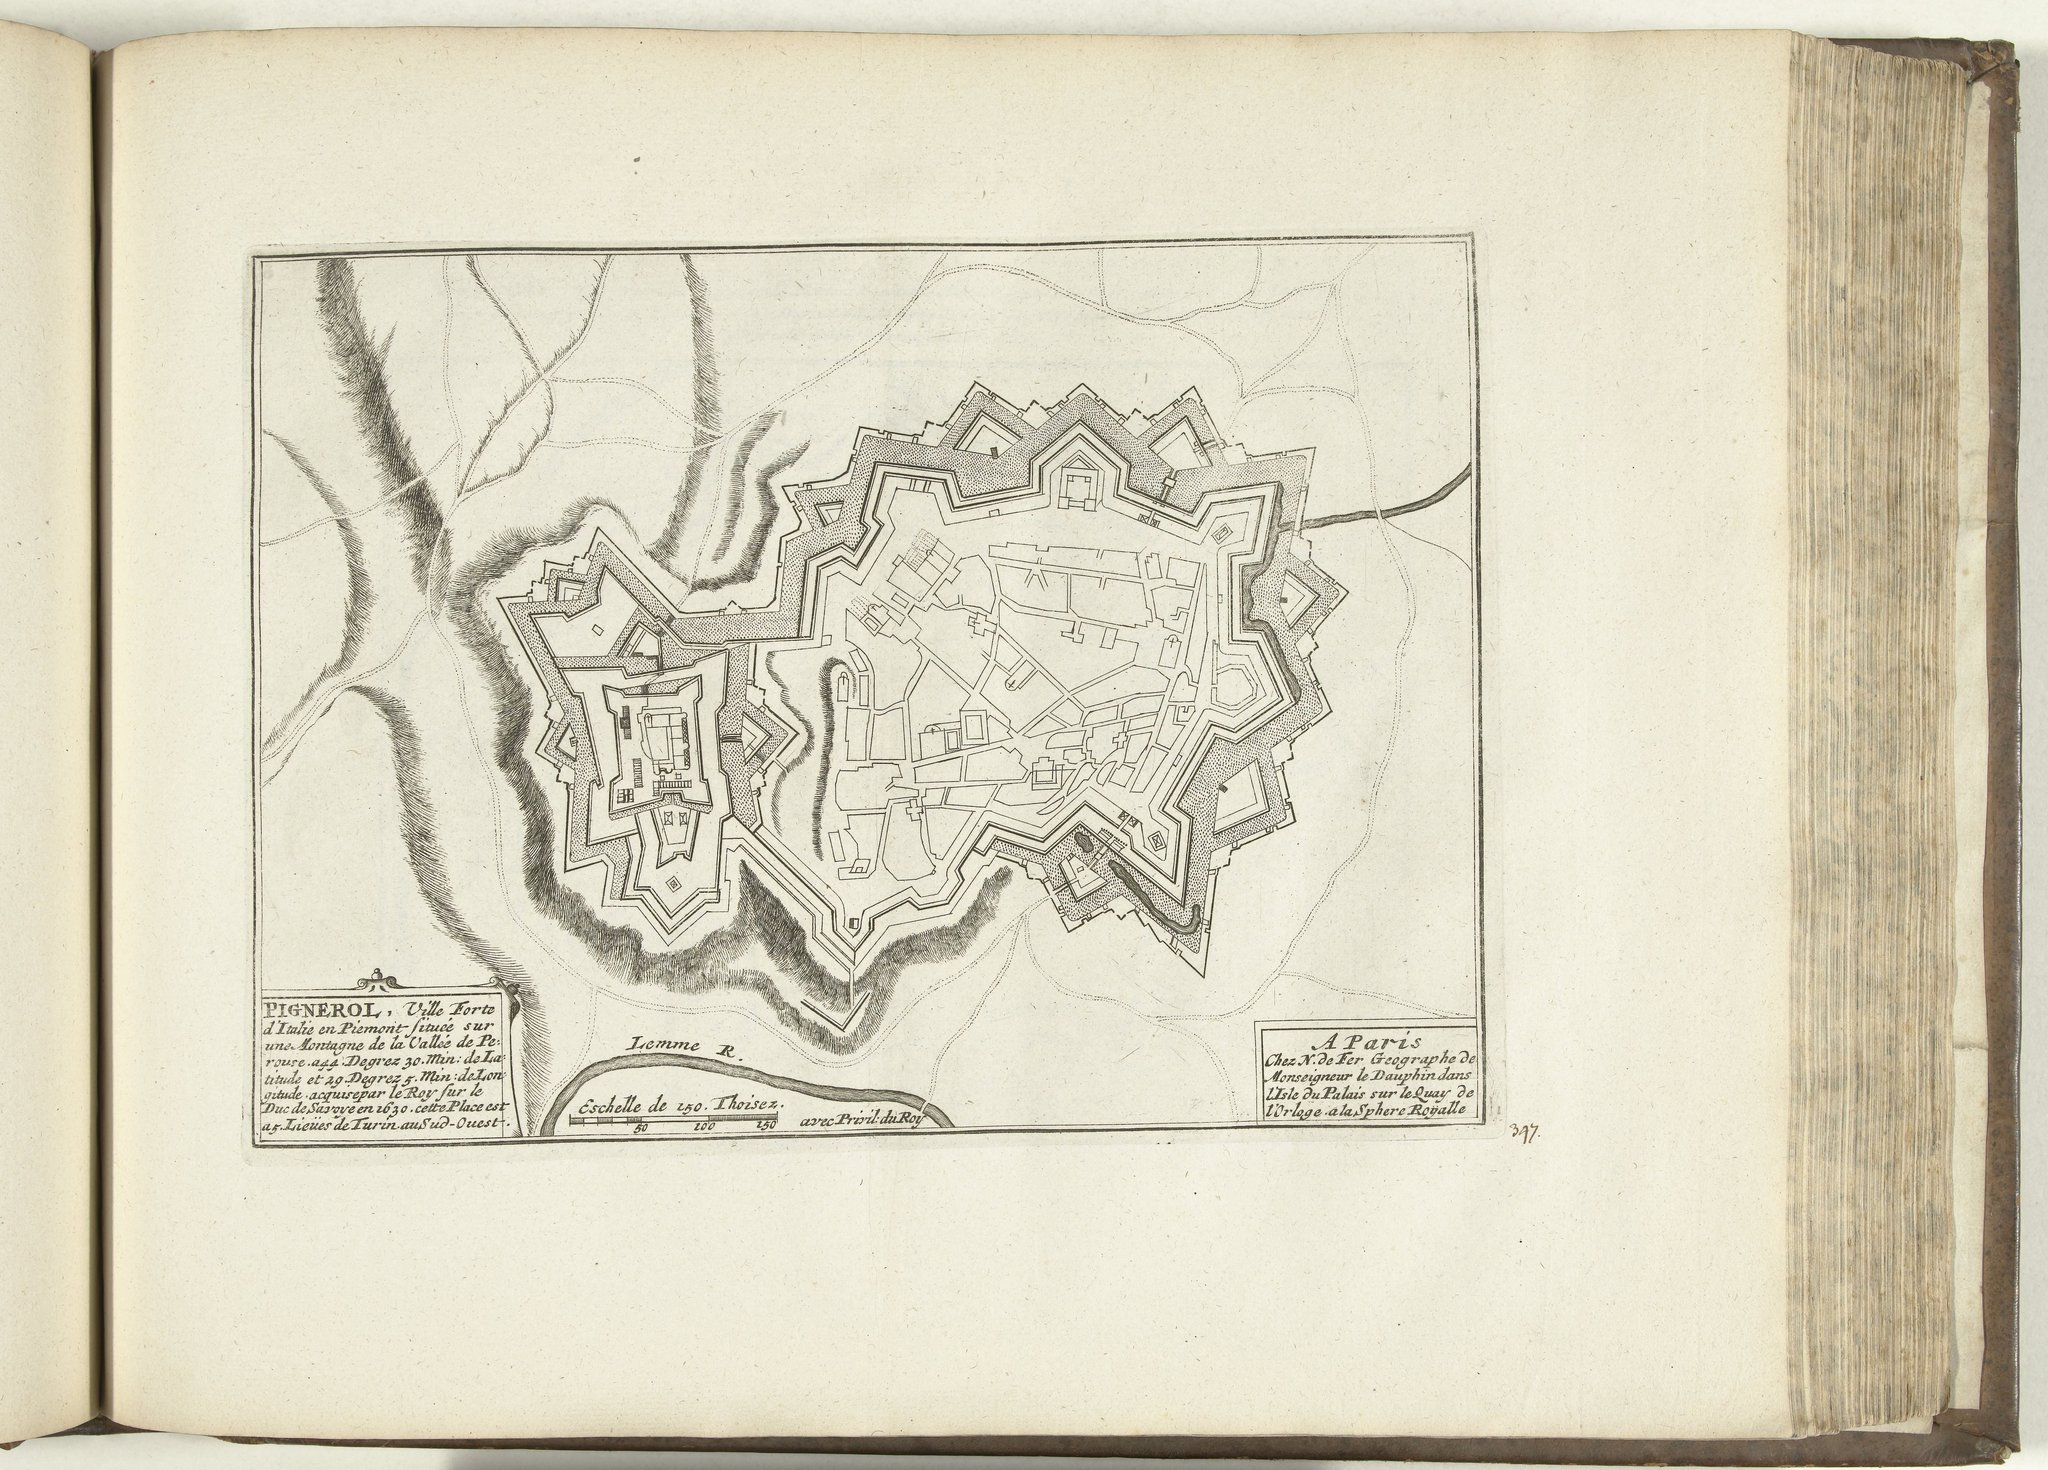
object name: print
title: Pignerol, Ville Forte d'Italie en Piemont (...)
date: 1726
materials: paper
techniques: etching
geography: northern netherlands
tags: fortress, maps of cities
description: Plattegrond van de versterkingen om de Italiaanse stad Pinerolo (Pignerol). Plaat nr. 347 in deel XIV van het prentwerk: Les Forces de l'Europe, Asie, Afrique et Amerique ... Comme aussi les Cartes des Côtes de France et d'Espagne uit 1726, dit tweede deel met 271 met de hand genummerde platen van vermaarde sterke steden en vestingen in het kader van de Spaanse Successieoorlog 1701-1713. Voor het merendeel zijn deze platen gekopieerd naar de anonieme Franse platen van vermaarde sterke steden en vestingen: in Les forces de l'Europe en in: Le theatre de la guerre, dans les Pays-Bas, beide oorspronkelijk uitgegeven door Nicolas de Fer te Parijs (1693-1697) in het kader van de Negenjarige Oorlog. Titel en opschriften in het Frans.